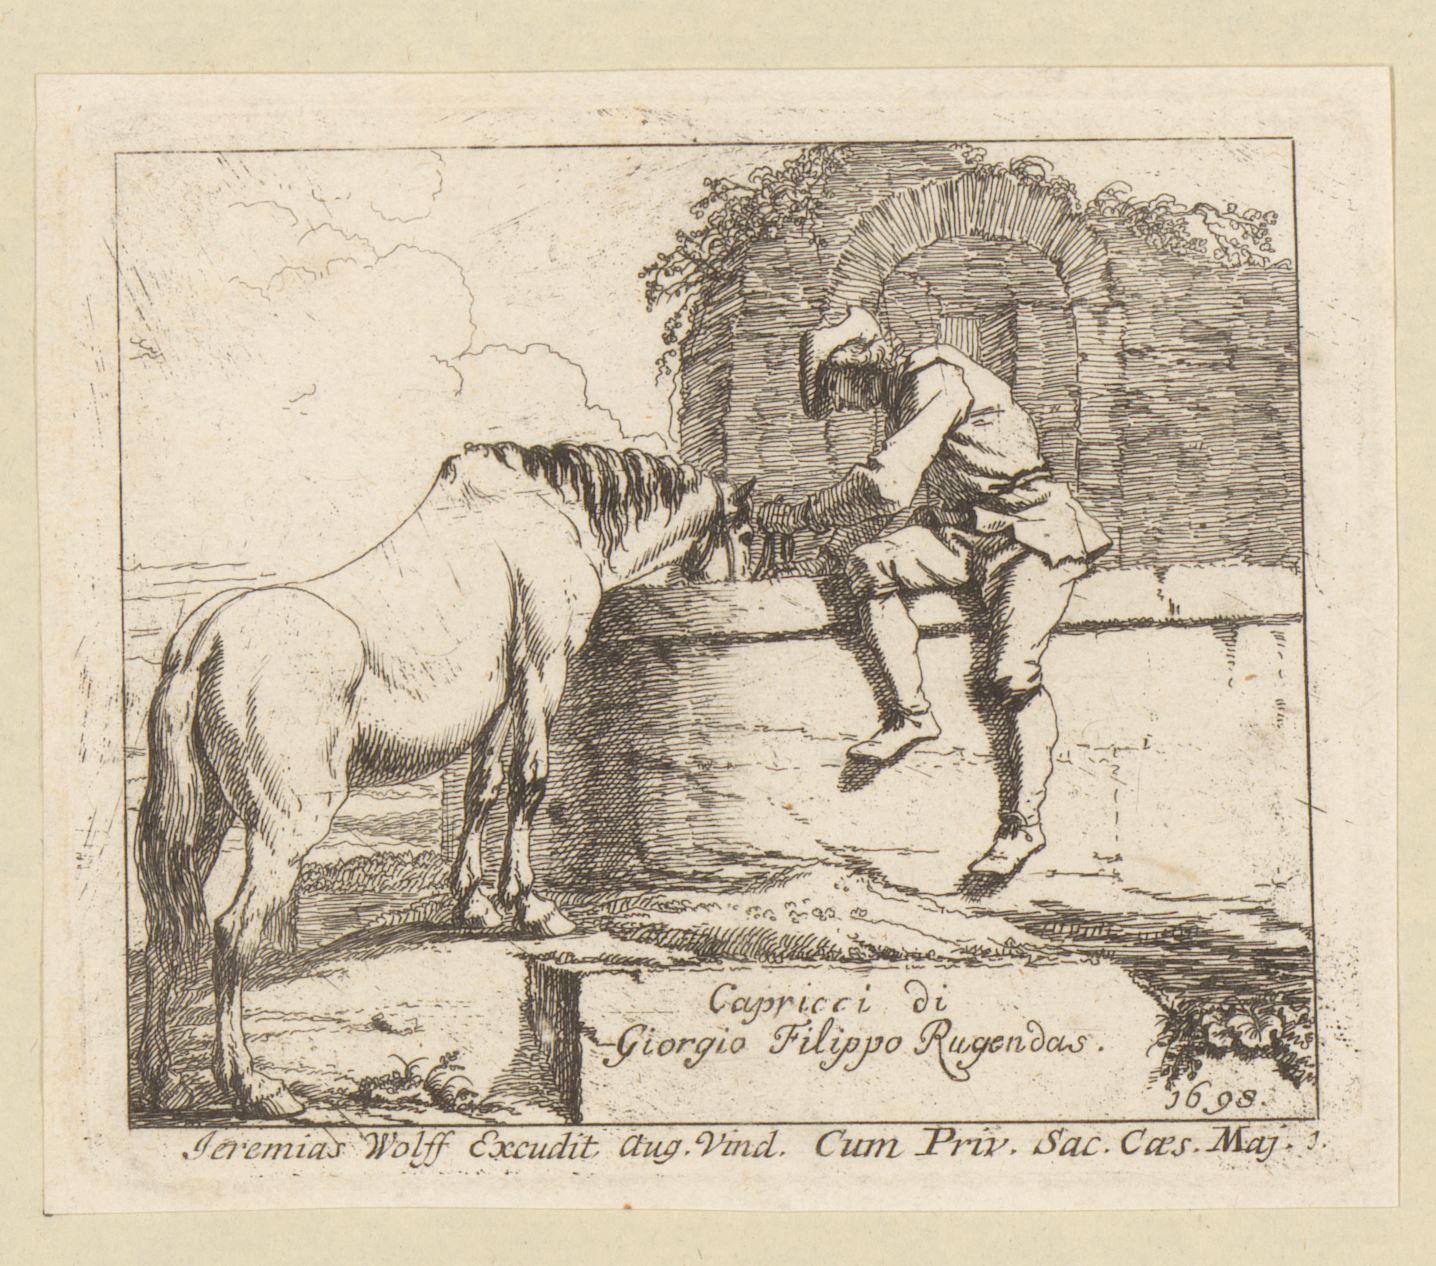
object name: print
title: Capricci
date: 1698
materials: paper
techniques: etching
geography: augsburg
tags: riding a horse, ass, or mule; rider, horseman, well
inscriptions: collector's mark: Lugt 240